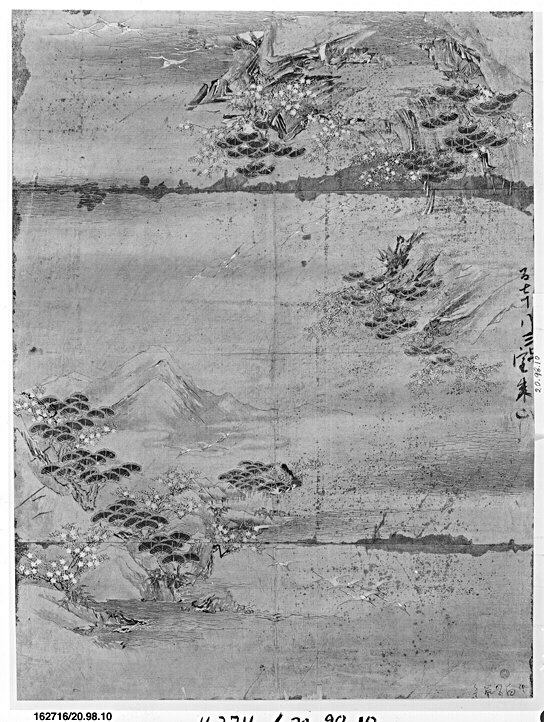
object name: textile design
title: Textile Design for Stencil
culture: japanese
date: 1601-1700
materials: paint, paper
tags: mountains